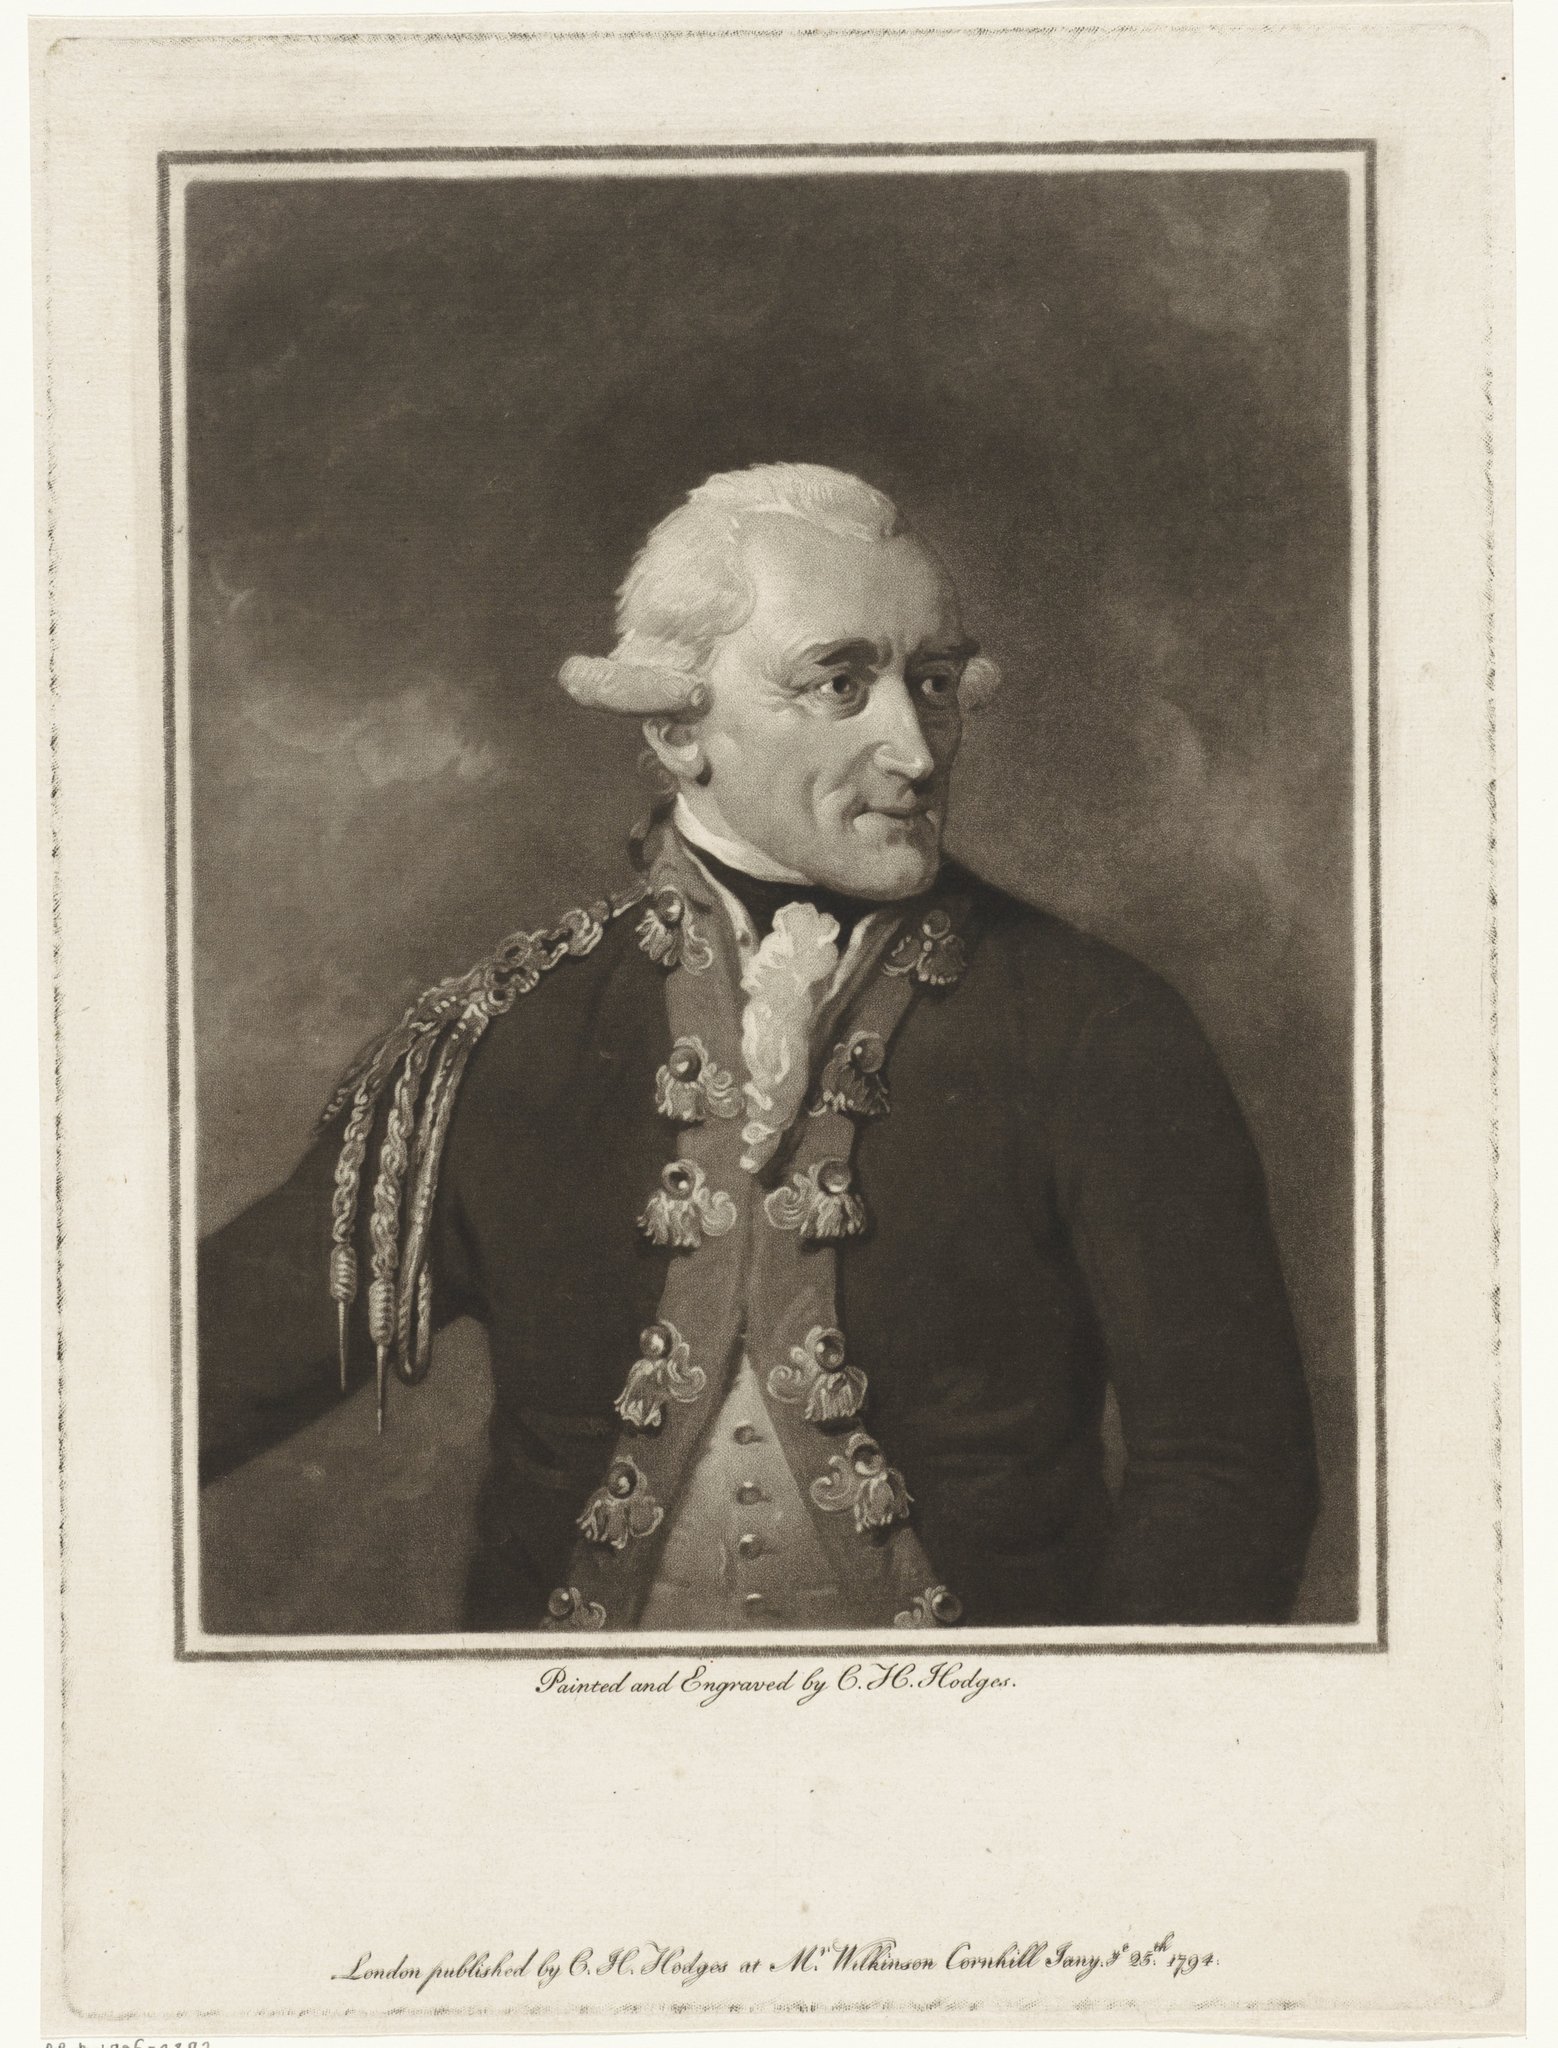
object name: print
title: Portret van Carel Baron van Boetzelaer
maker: charles howard hodges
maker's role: draughtsman, painter, print maker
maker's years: 1764-1837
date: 1794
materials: paper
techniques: engraving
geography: london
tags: the hague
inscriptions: collector's mark: Lugt 2228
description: Carel Baron van Boetzelaer, luitenant-generaal en commandeur van Willemstad.